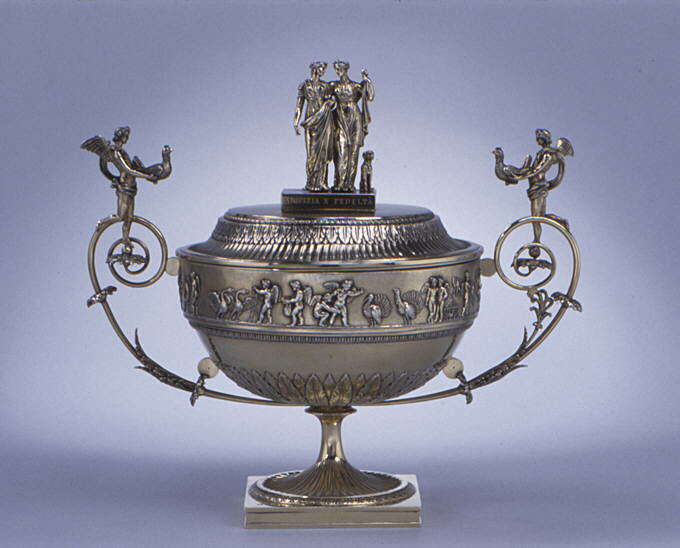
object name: sugar bowl with cover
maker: giovacchino belli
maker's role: maker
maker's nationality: italian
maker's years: 1756-1822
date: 1811-1822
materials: silver gilt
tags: birds,women,putti,dogs